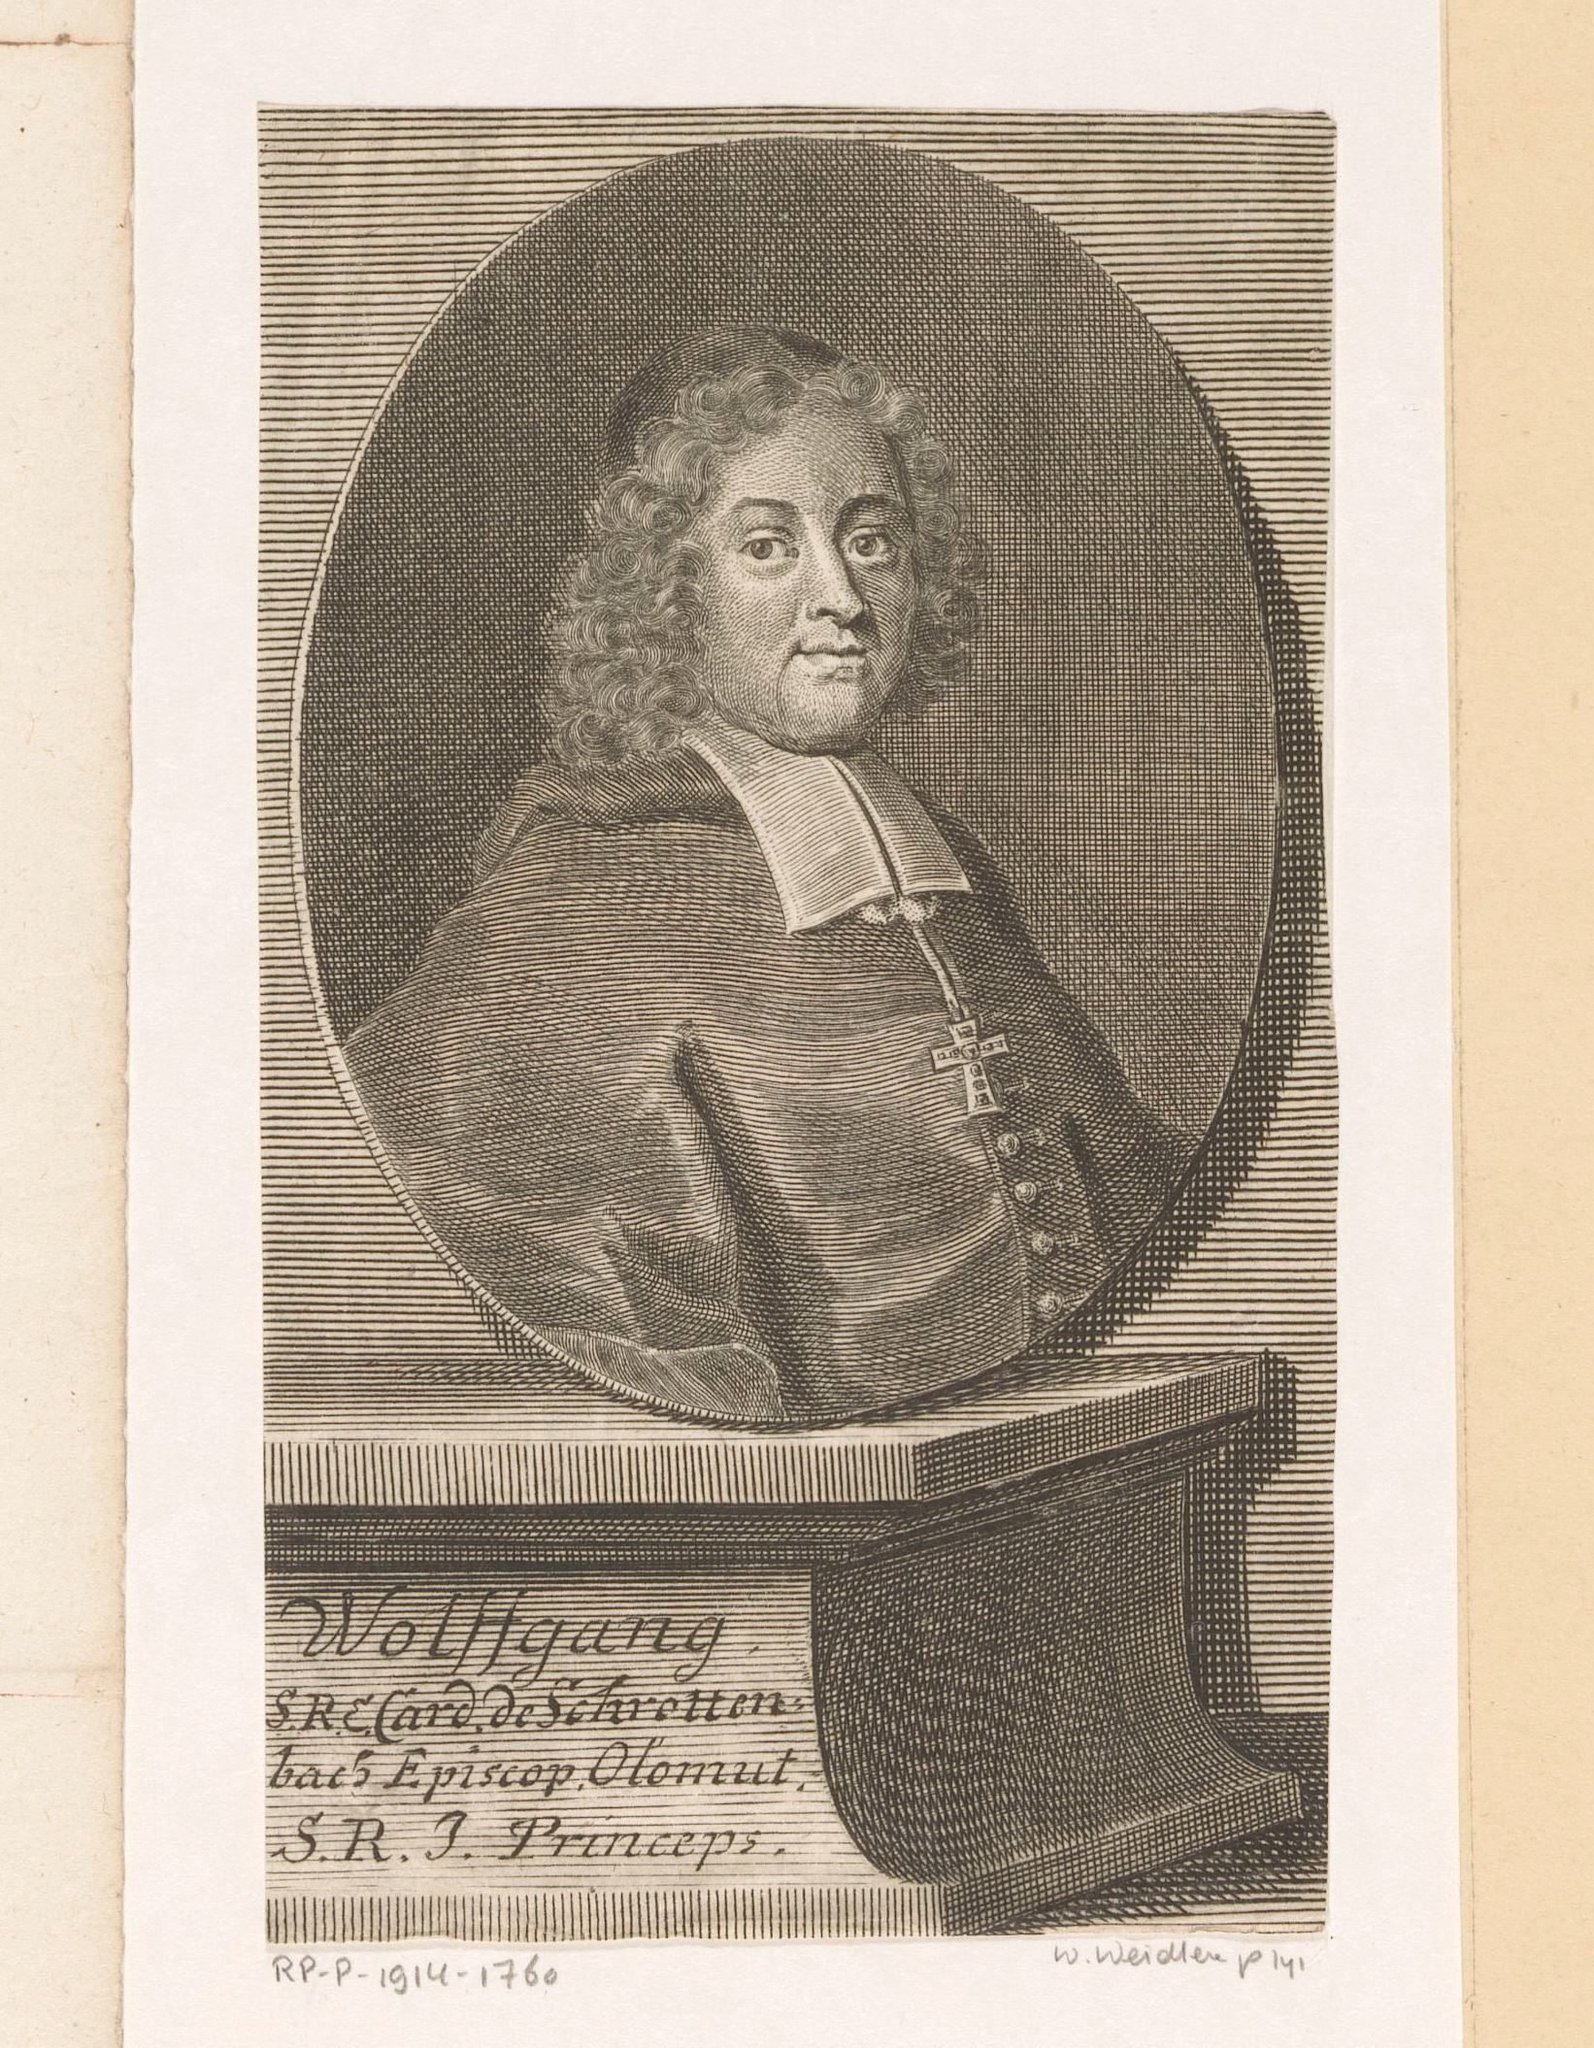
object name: print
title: Portret van Wolfgang Hanibal von Schrattenbach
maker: martin bernigeroth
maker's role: print maker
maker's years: 1670-1733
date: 1713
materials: paper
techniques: engraving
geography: leipzig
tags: historical persons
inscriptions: collector's mark: Lugt 2228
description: Prent ook gebruikt in: Die Europäische Fama, Welche den gegenwärtigen Zustand der vornehmsten Höfe entdecket. dl. 151. Leipzig: Gleditsch, 1713.